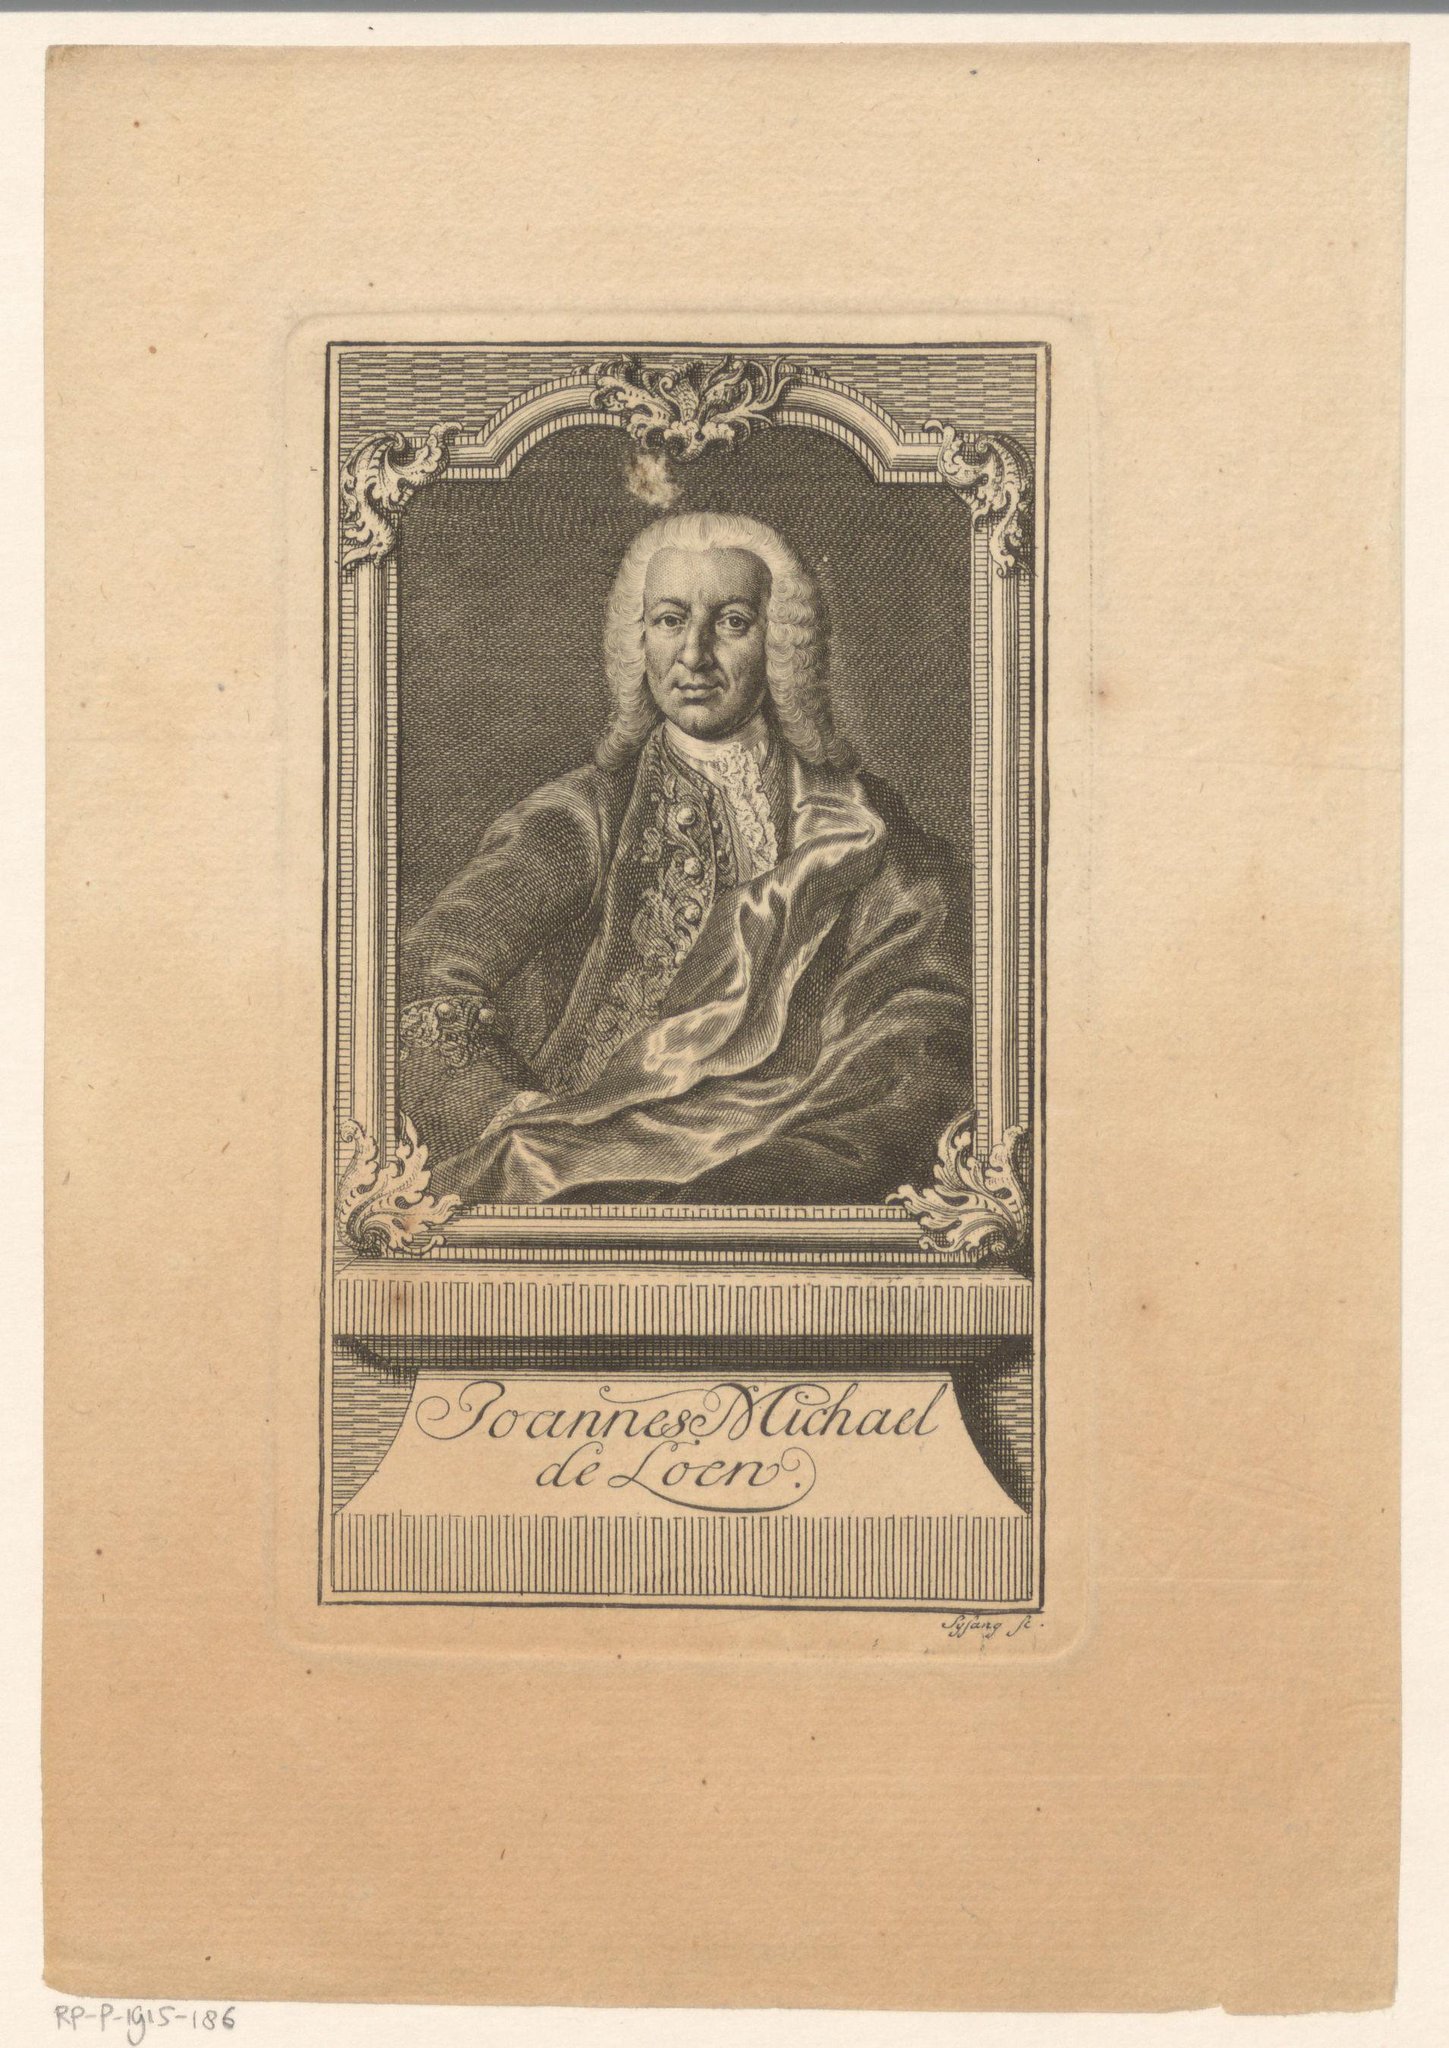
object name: print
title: Portret van Johan Michael von Loën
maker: johann christoph sysang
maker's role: print maker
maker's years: 1703-1757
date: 1752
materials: paper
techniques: engraving, etching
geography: leipzig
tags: historical persons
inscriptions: collector's mark: Lugt 2228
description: Prent gebruikt voor de publicatie: Zuverlässige Nachrichten von dem gegenwärtigen Zustande, Veränderung und Wachsthum der Wissenschaften. Leipzig: Johann Friedrich Gleditsch, 1752, dl. 147.